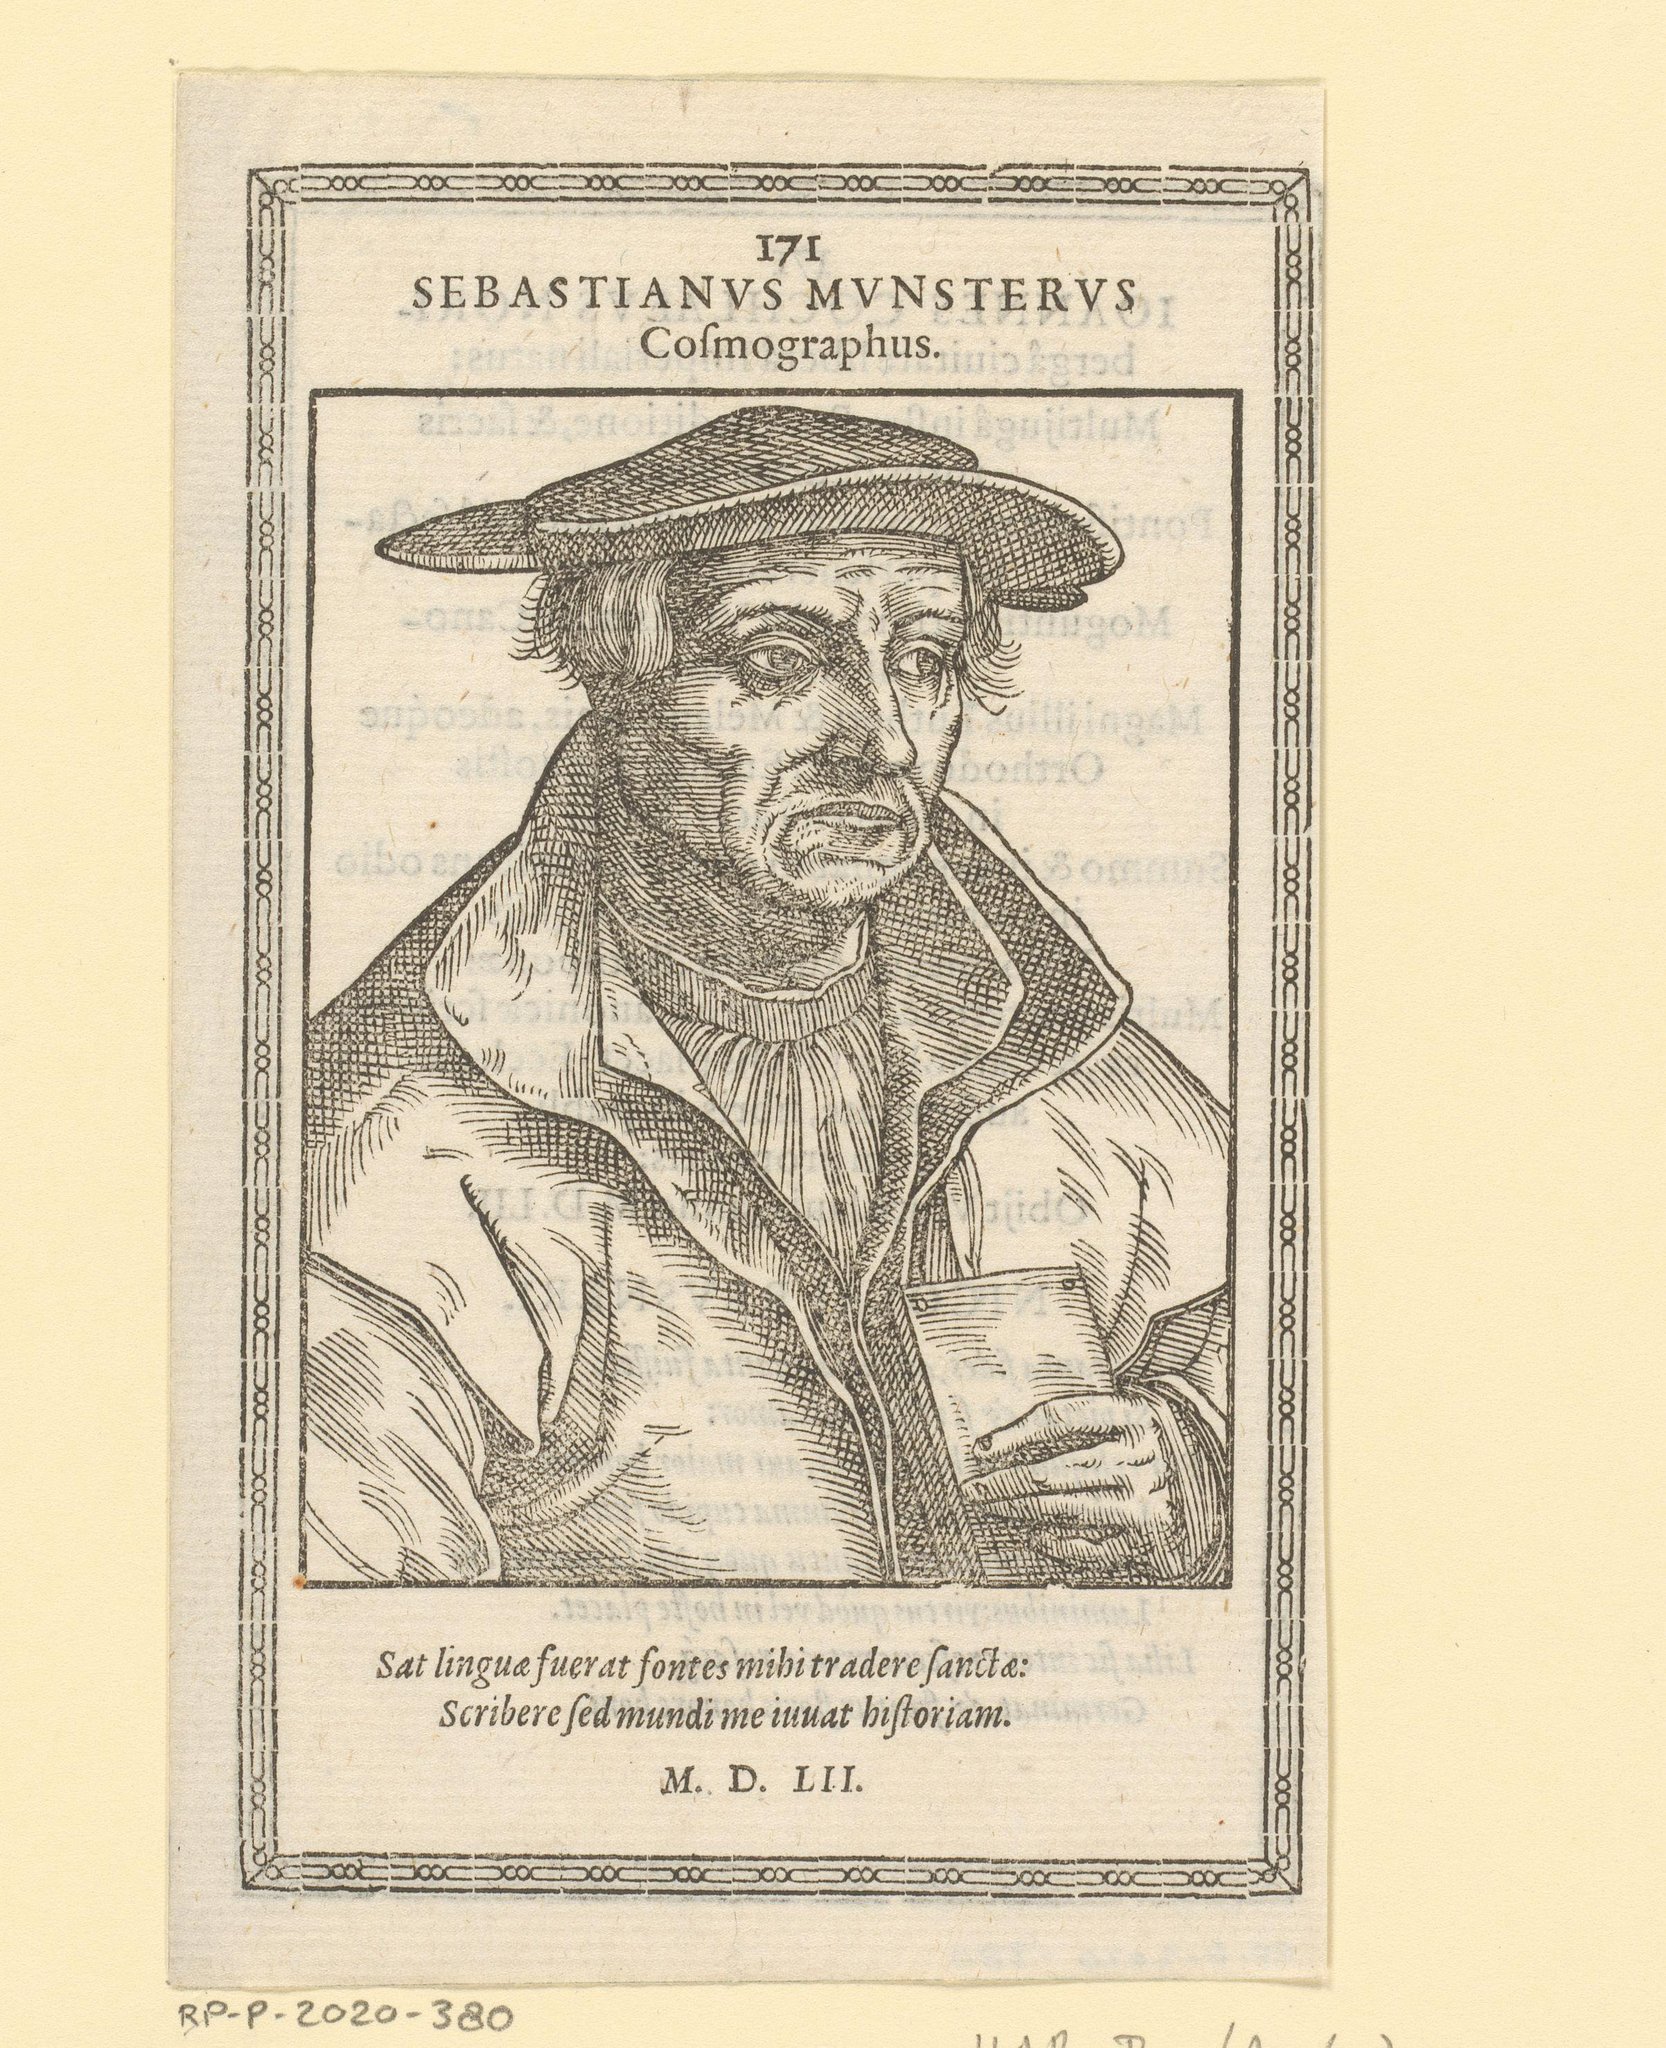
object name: print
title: Portret van Sebastian Münster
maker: bernhard jobin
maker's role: printer, publisher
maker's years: 1545-1593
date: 1590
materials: paper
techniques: letterpress printing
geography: straatsburg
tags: scholar, philosopher, historical persons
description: Prent uit: Reusner, Nikolaus. Icones sive imagines virorum literis illustrium (...). Straatsburg: Bernhard Jobin, 1590, p. 171. Prent voor het eerst verschenen in de eerste editie van 1587. Prent ook gebruikt in latere publicaties.